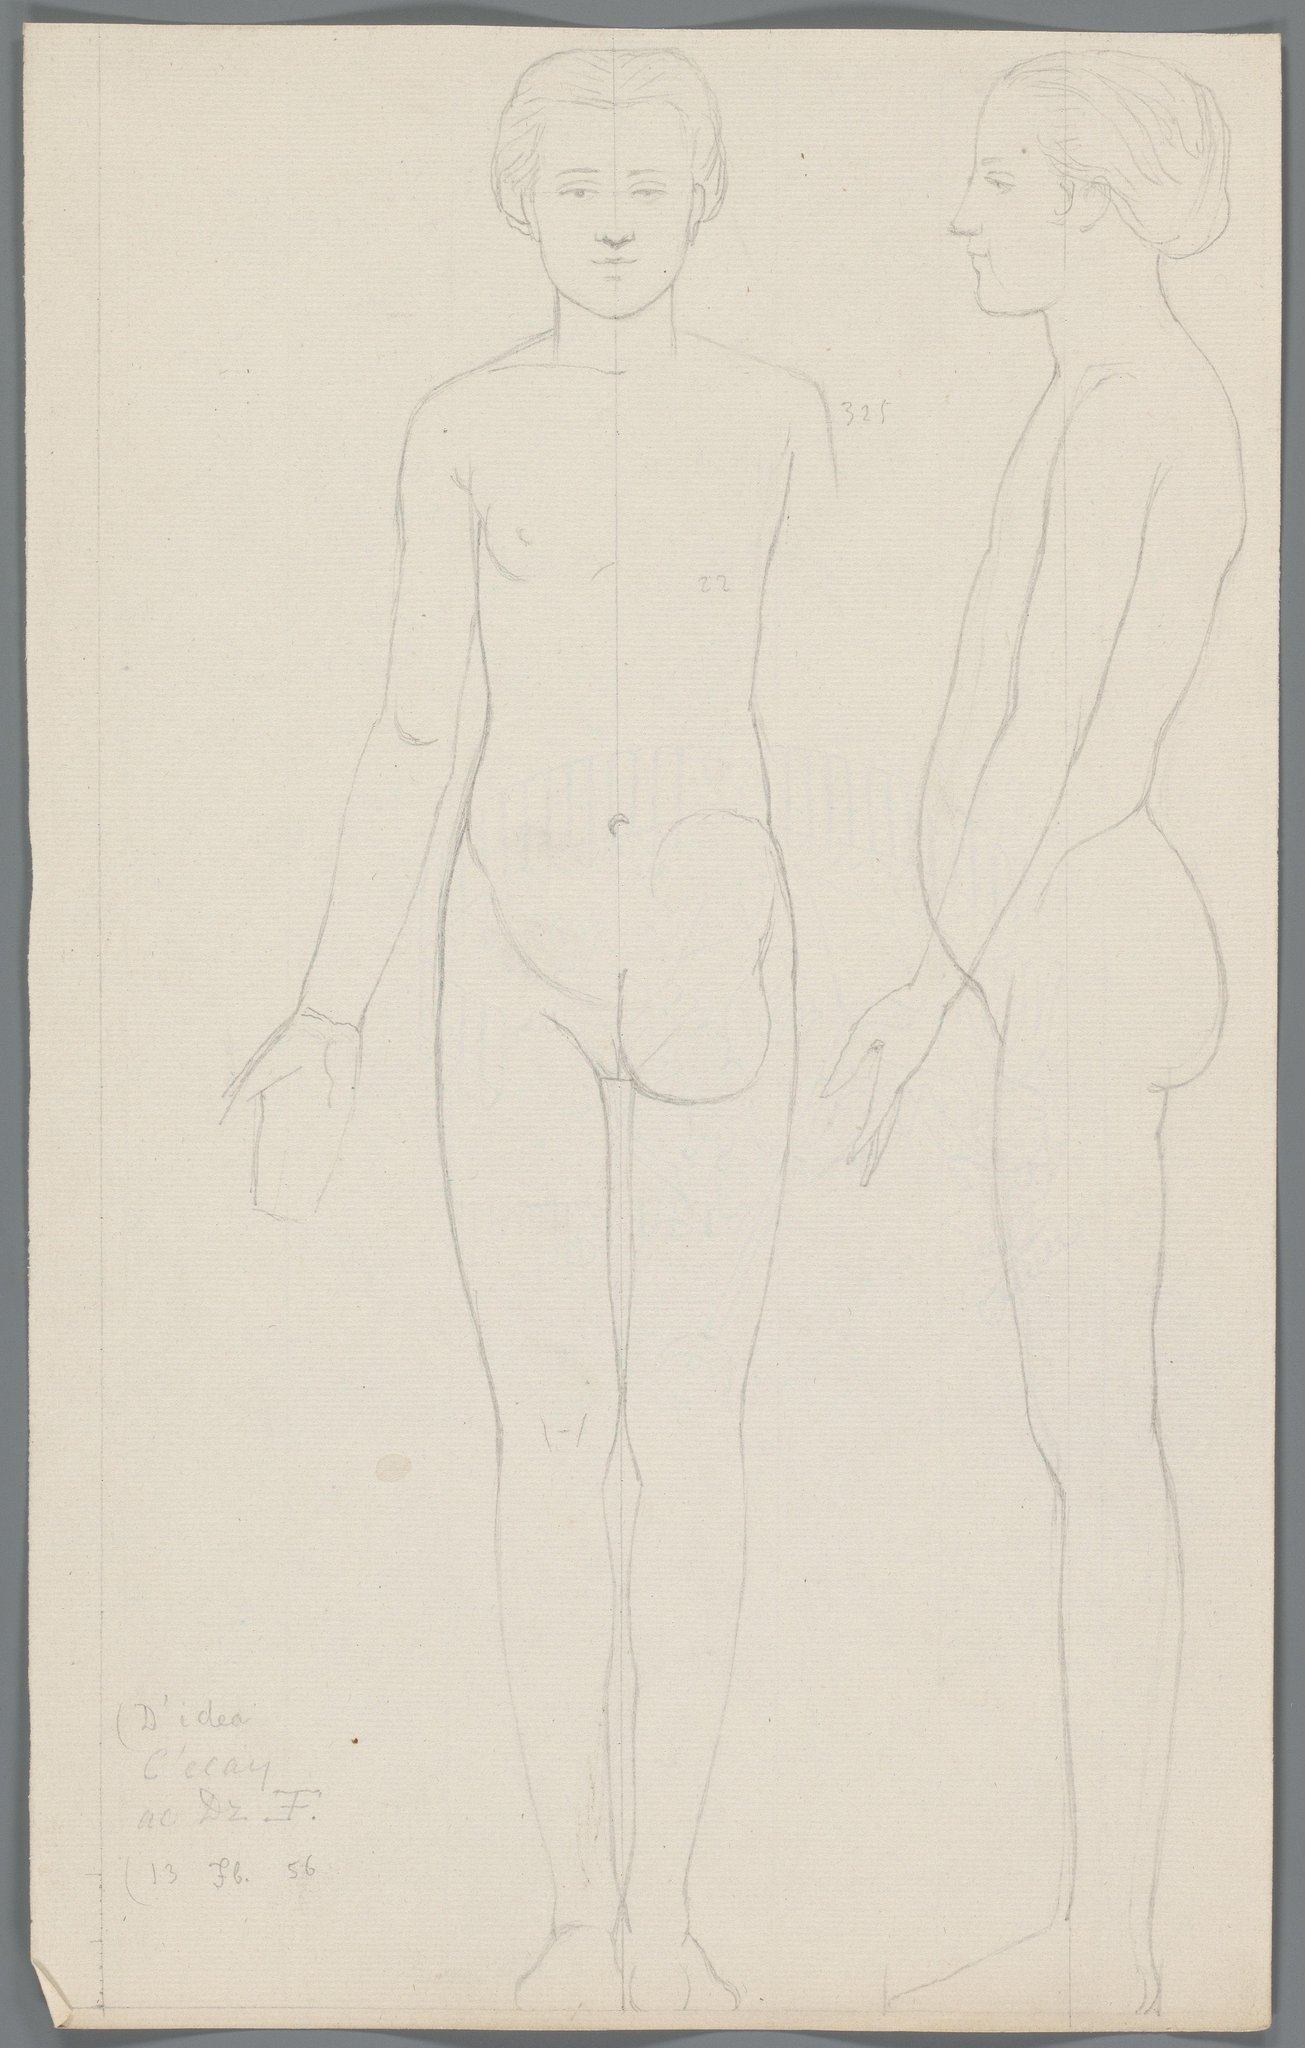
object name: drawing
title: Proportiestudie van een meisje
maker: jacobus everhardus josephus van den berg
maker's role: draughtsman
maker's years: 1802-1861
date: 1856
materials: paper, pencil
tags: anatomy (non-medical), standing figure (canon, proportions) - aa - female human figure, child (at home) - aa - girl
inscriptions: inscription: ‘D'idea/ C'ecay/ ac Dr EF/ 13 fb 56’